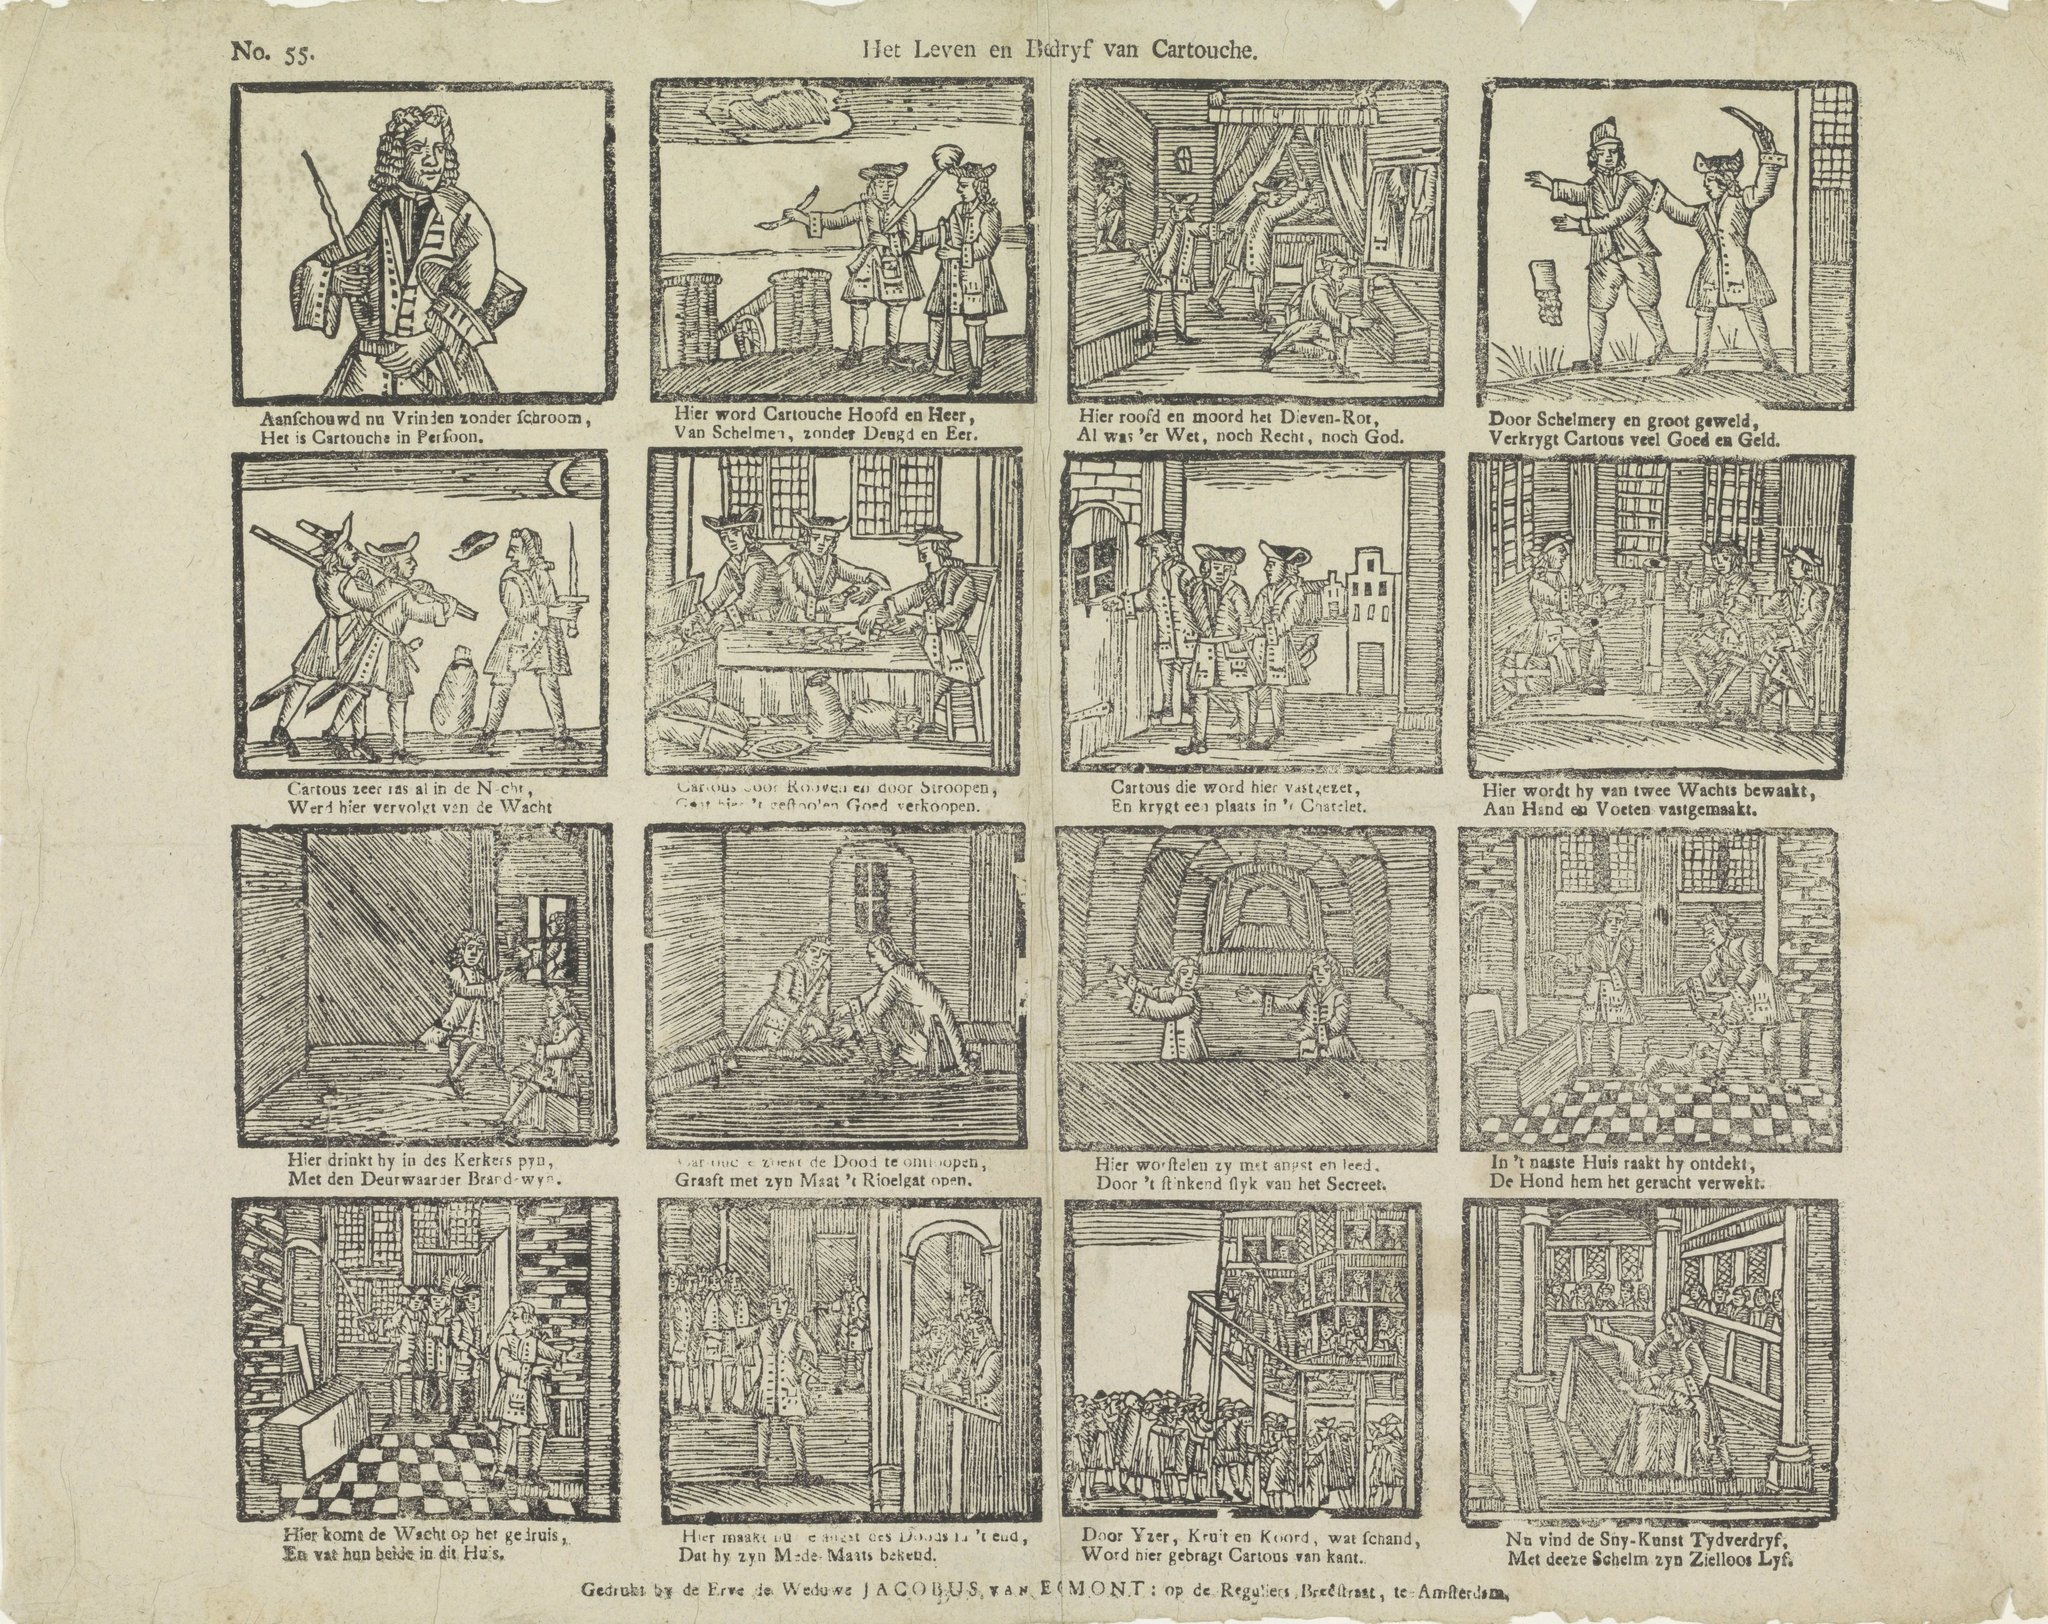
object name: print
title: Het leven en bedryf van Cartouche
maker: Anonymous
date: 1761-1804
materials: paper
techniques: letterpress printing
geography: amsterdam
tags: bad behaviour, tales and fairy tales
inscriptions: collector's mark: Lugt 2228, collector's mark: Lugt 2760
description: Blad met 16 voorstellingen over het leven en avonturen van Cartouche. Onder elke afbeelding een tweeregelig vers. Genummerd linksboven: No. 55.